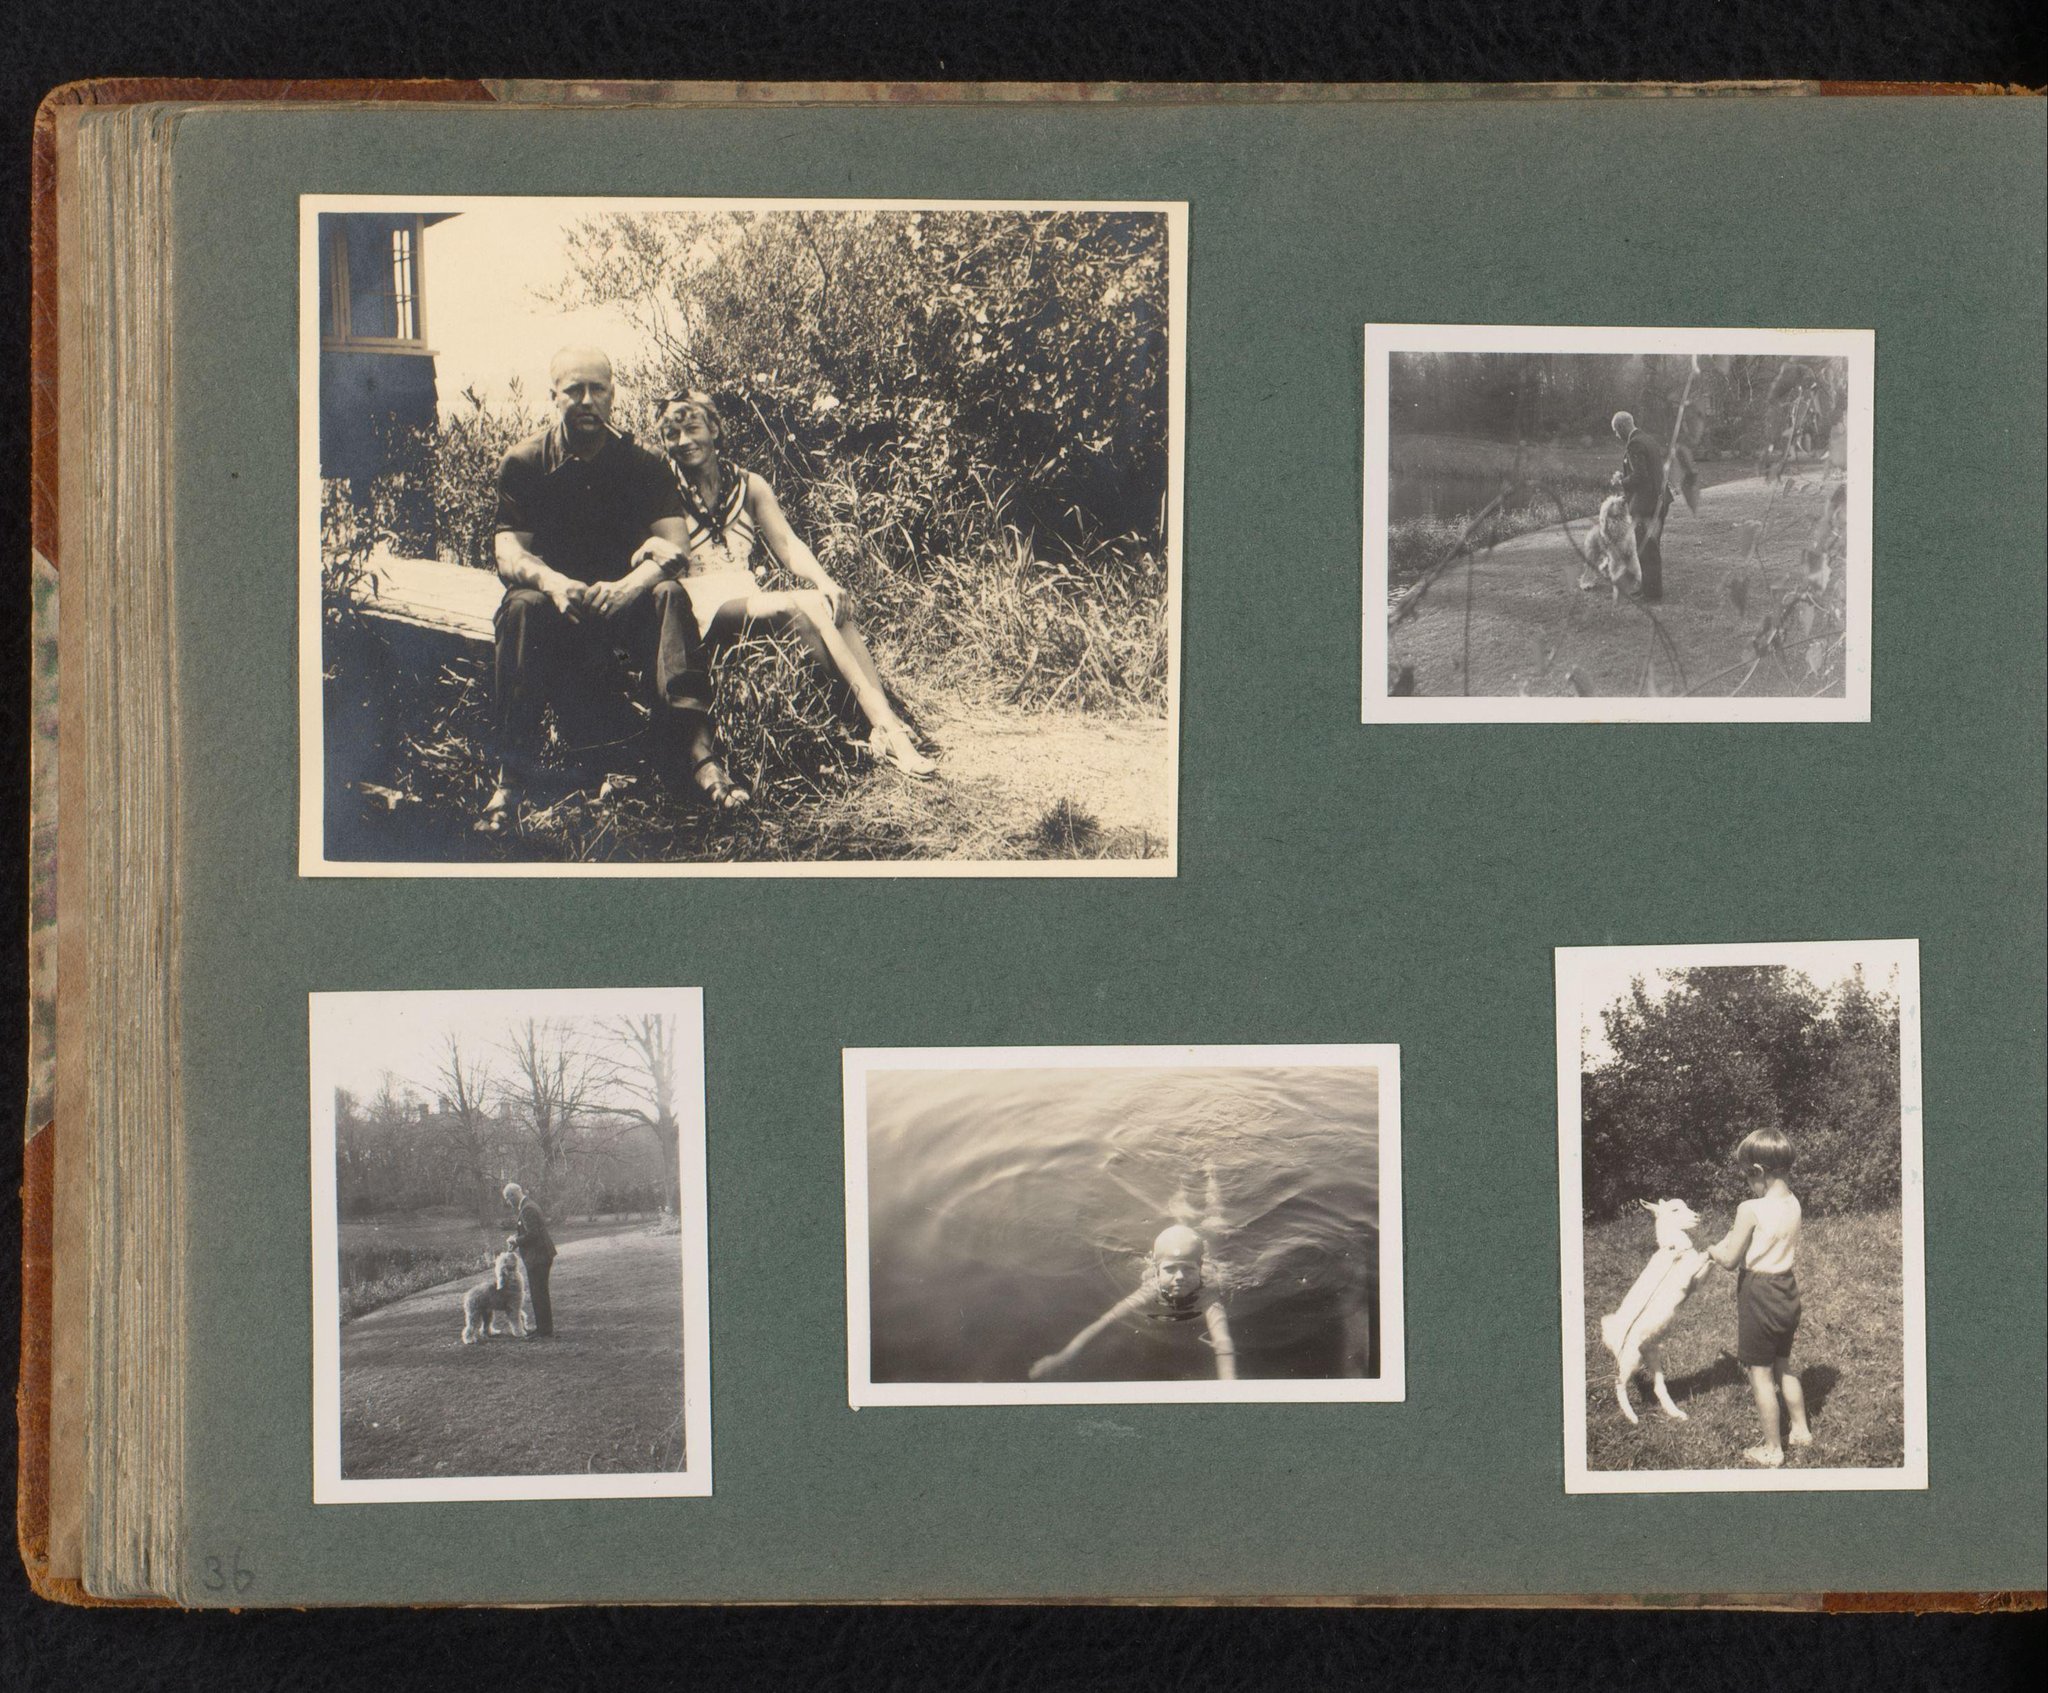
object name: photograph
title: Vijf foto's van familie Furnée-Onnen bij een meer of plas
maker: Anonymous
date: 1920-1930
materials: paper, cardboard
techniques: gelatin silver print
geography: netherlands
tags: the hague, family life, goat, dog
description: De jongen is waarschijnlijk Frank of Pieter Furnée.